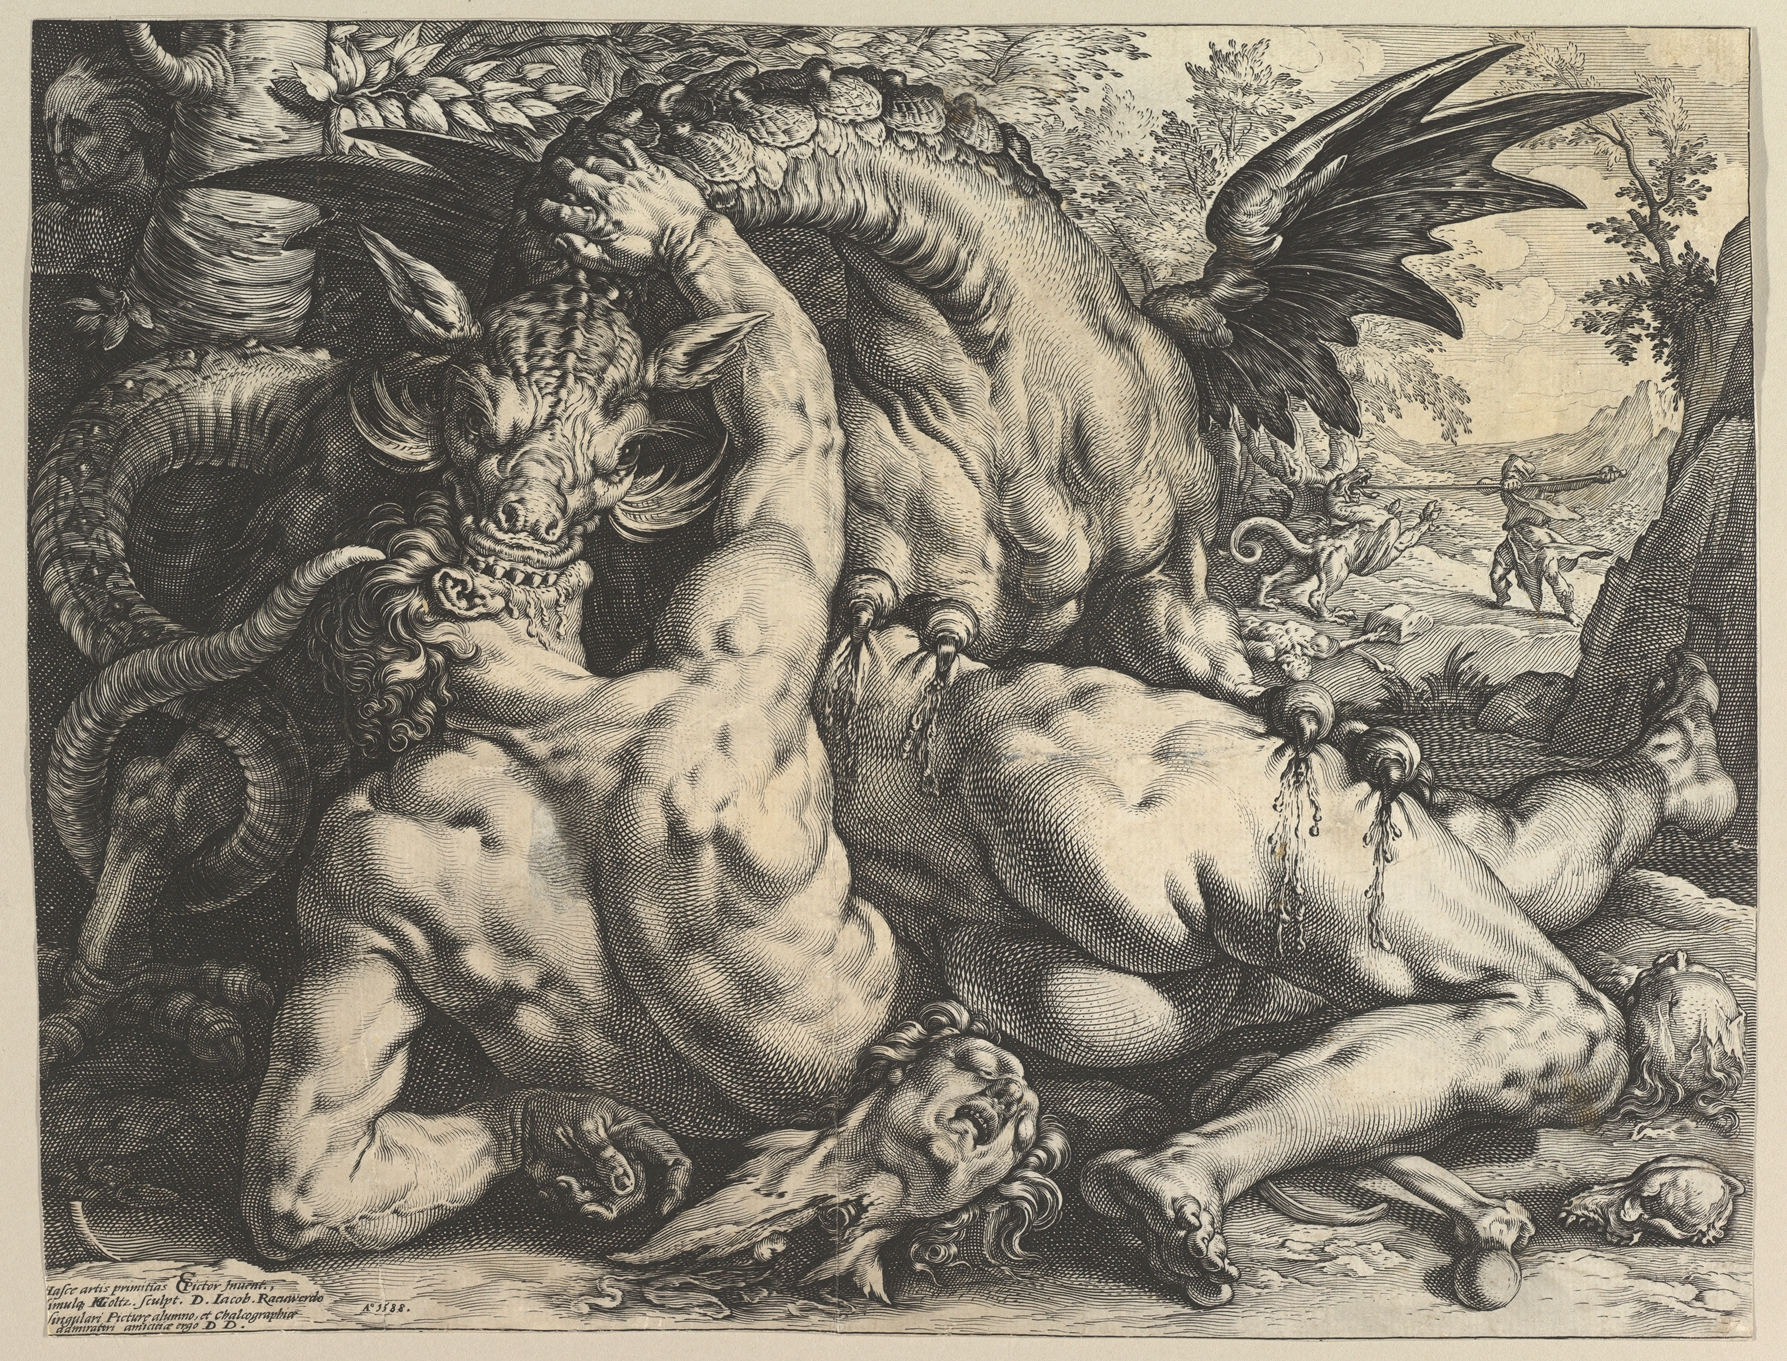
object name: print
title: The Dragon Devouring the Companions of Cadmus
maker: hendrick goltzius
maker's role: artist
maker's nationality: netherlandish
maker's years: 1558-1617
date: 1588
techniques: engraving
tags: heads,men,dragons